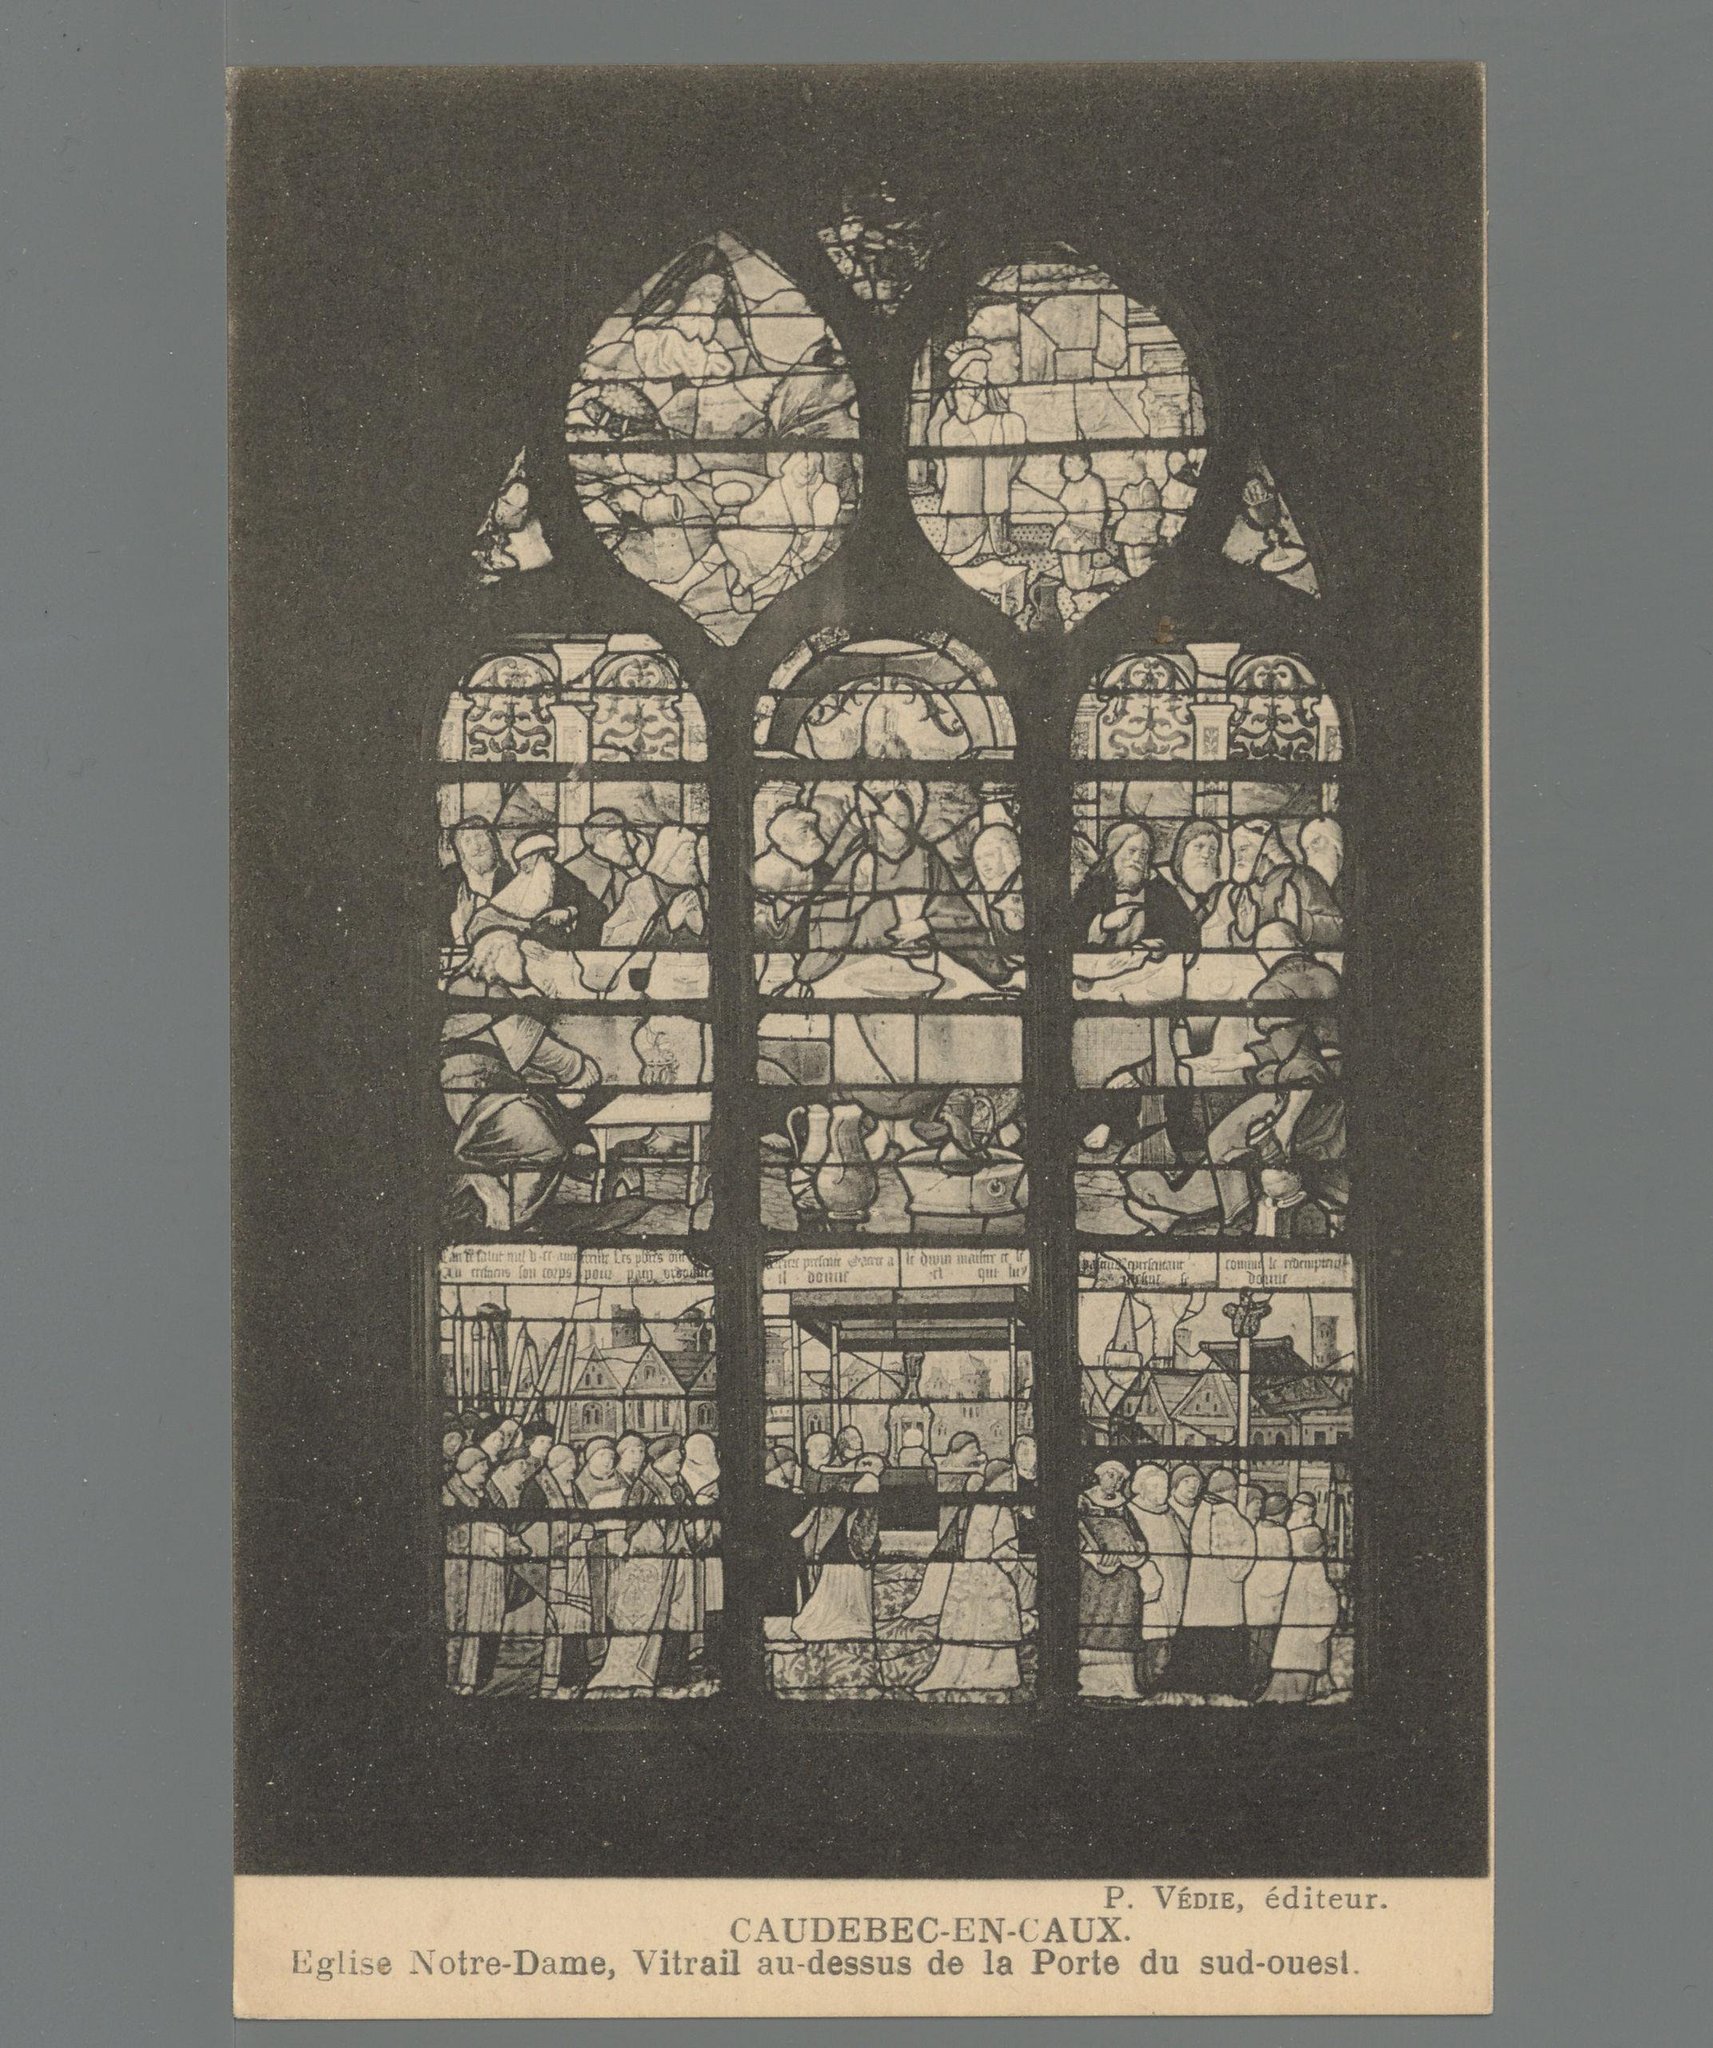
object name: ansichtkaart, prentbriefkaart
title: Caudebec-en Caux. Eglise Notre-Dame, Vitrail au-dessus de la Porte du sud-ouest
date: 1918-1920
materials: cardboard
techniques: photograph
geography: corbeil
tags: window, interior of church